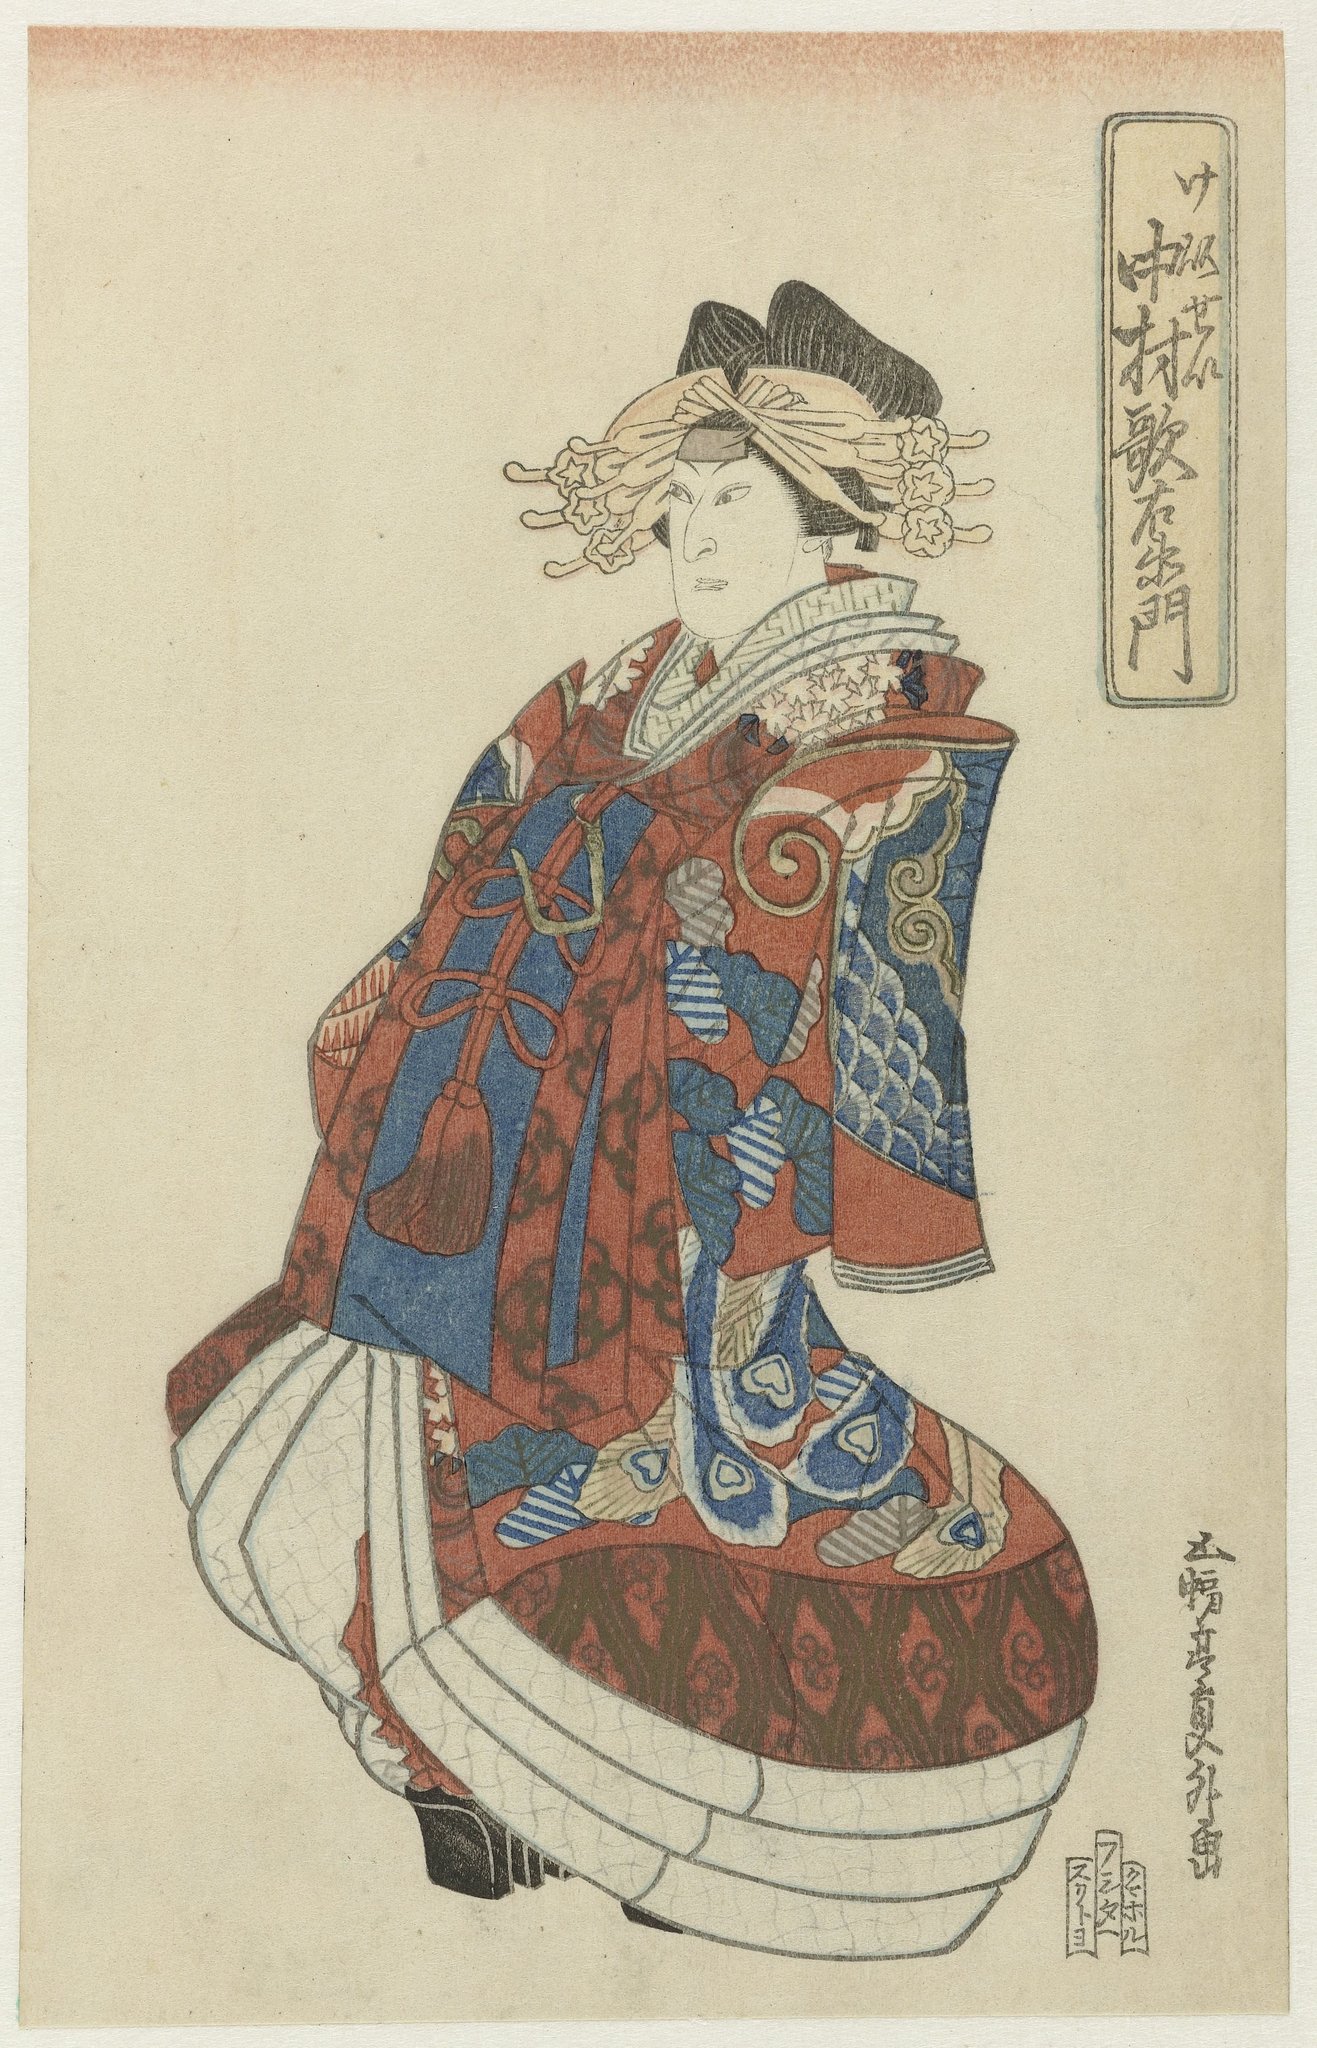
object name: print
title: Nakamura Utaemon als courtisane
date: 1838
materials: paper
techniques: woodcut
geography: osaka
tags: female impersonation by actor, courtesan, hetaera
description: Toneelspeler Nakamura Utaemon in de rol van courtisane met een kimono waarop een gestileerd vlindermotief. Scene uit het toneelstuk "Furumekashi keredo yahari nanakabe", opgevoerd in het Naka Theater, in de eerste maand van 1838.